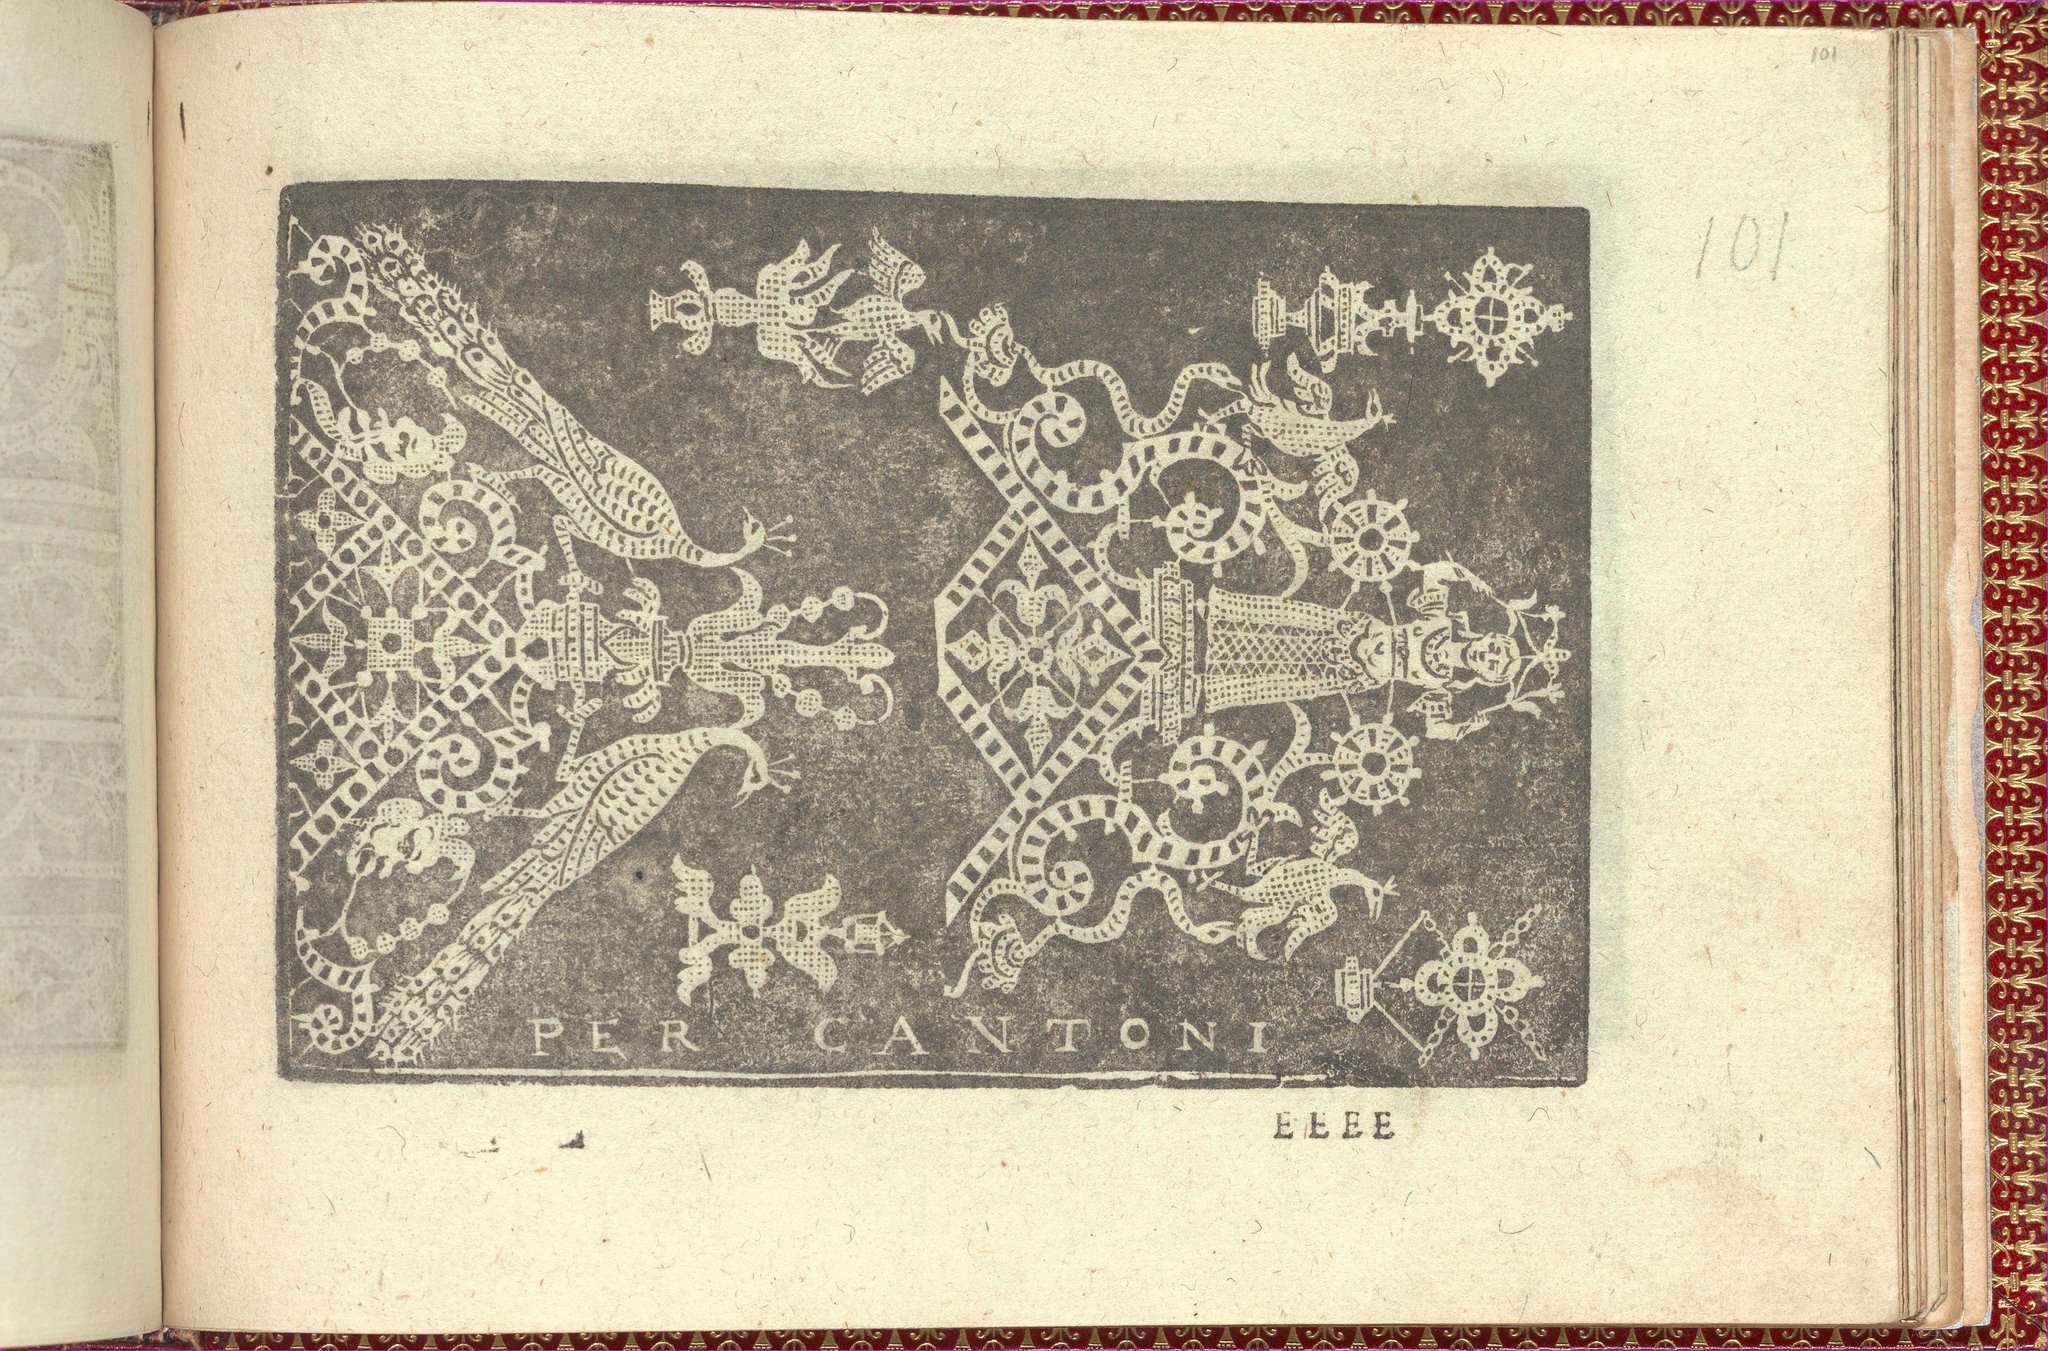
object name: book print ornament architecture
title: Corona delle Nobili et Virtuose Donne: Libro I-IV, page 101 (recto)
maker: cesare vecellio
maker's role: publisher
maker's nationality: italian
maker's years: 1521-1601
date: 1601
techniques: woodcut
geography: italy